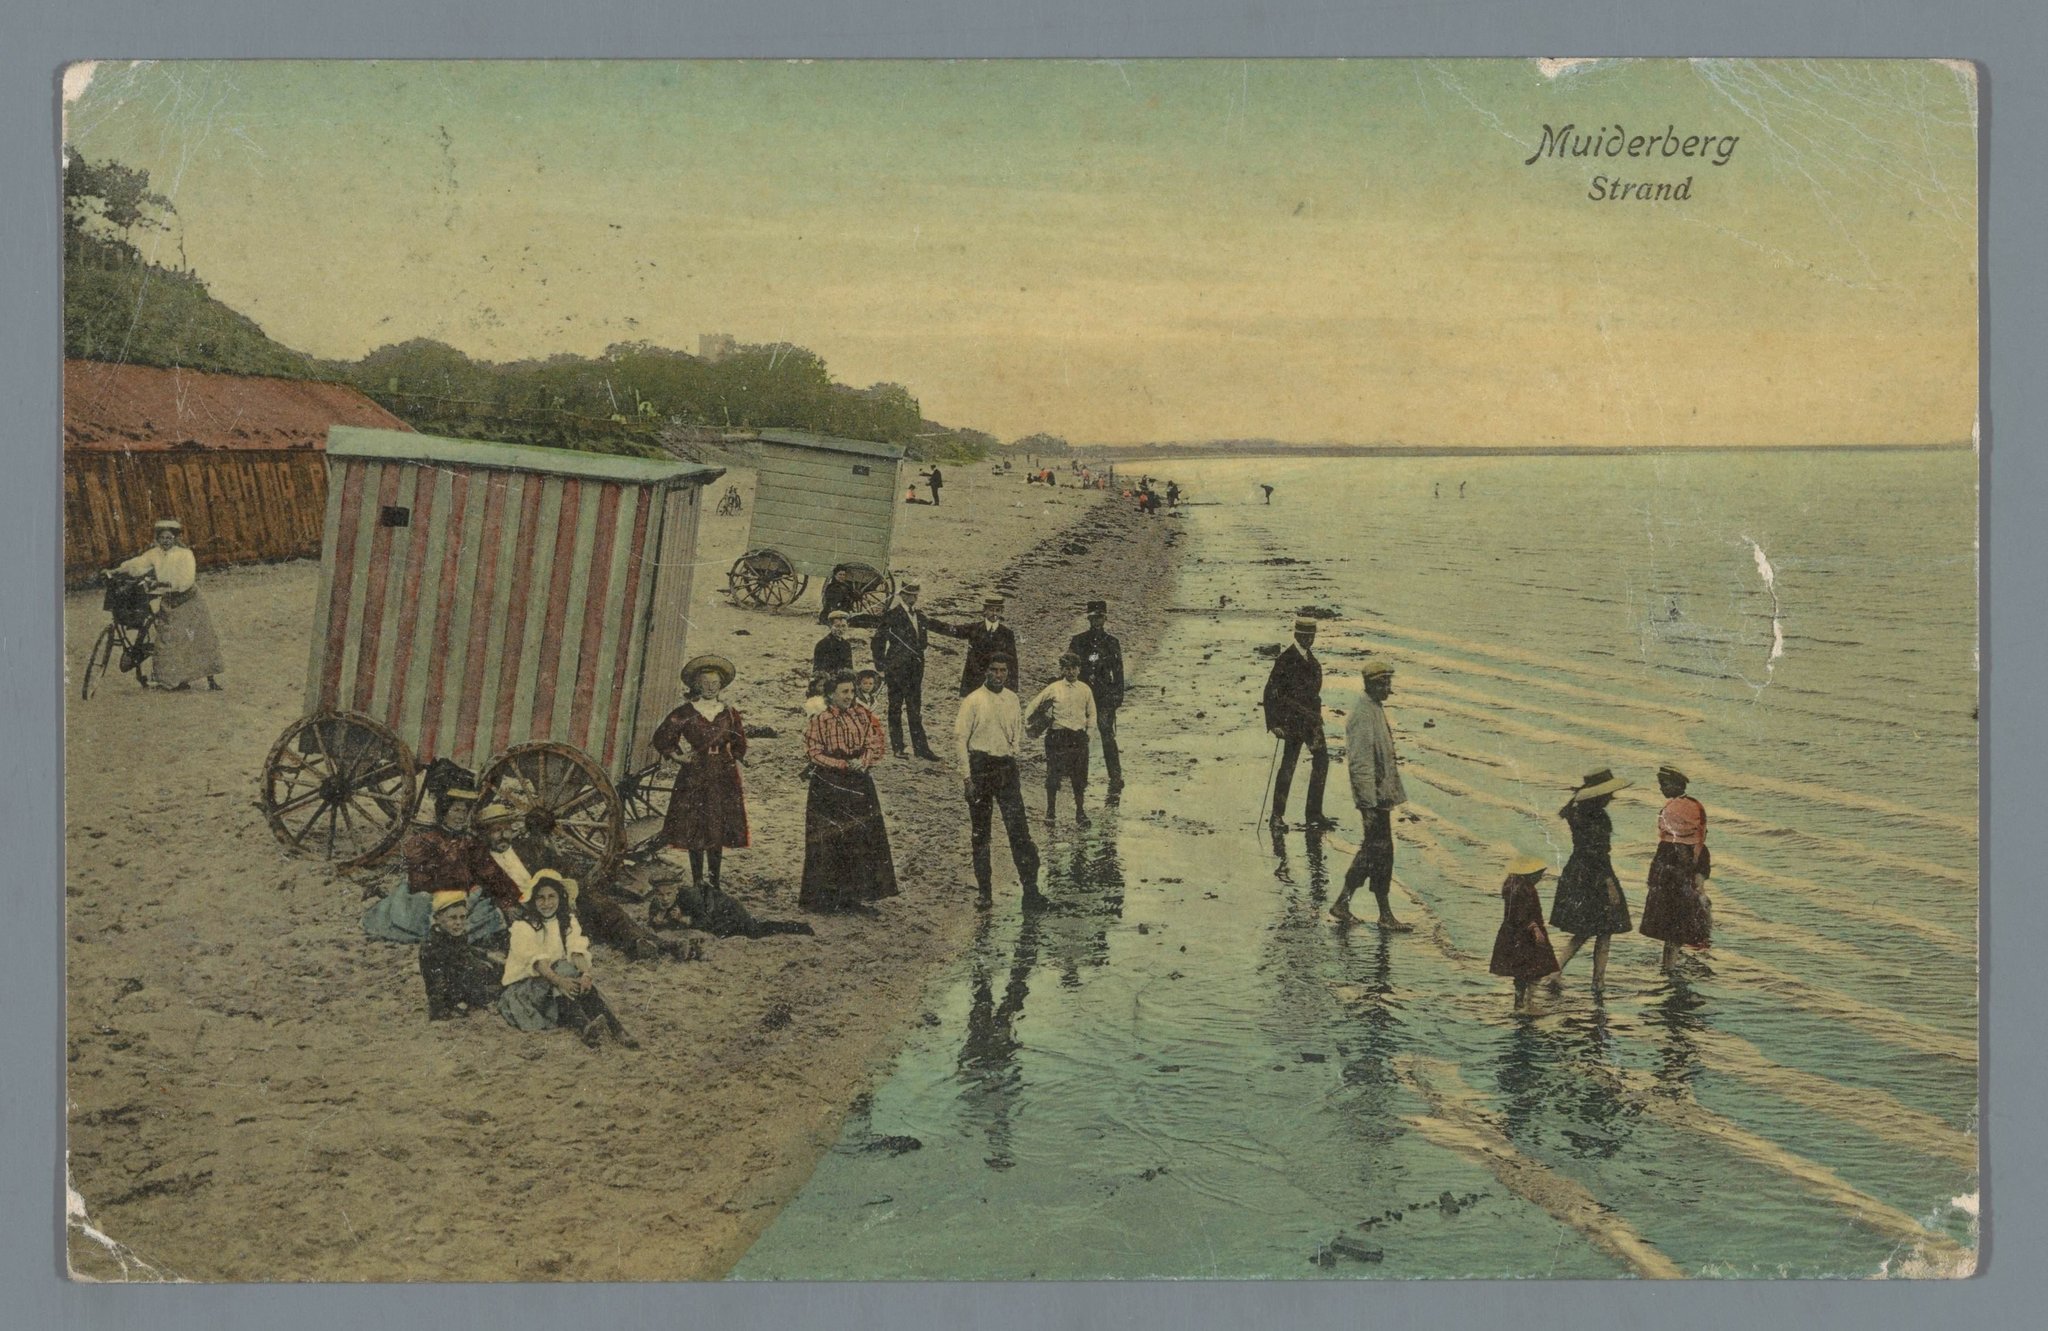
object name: ansichtkaart, prentbriefkaart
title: Muiderberg, Strand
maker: Anonymous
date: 1890-1920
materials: cardboard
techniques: photograph, writing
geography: the hague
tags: coast